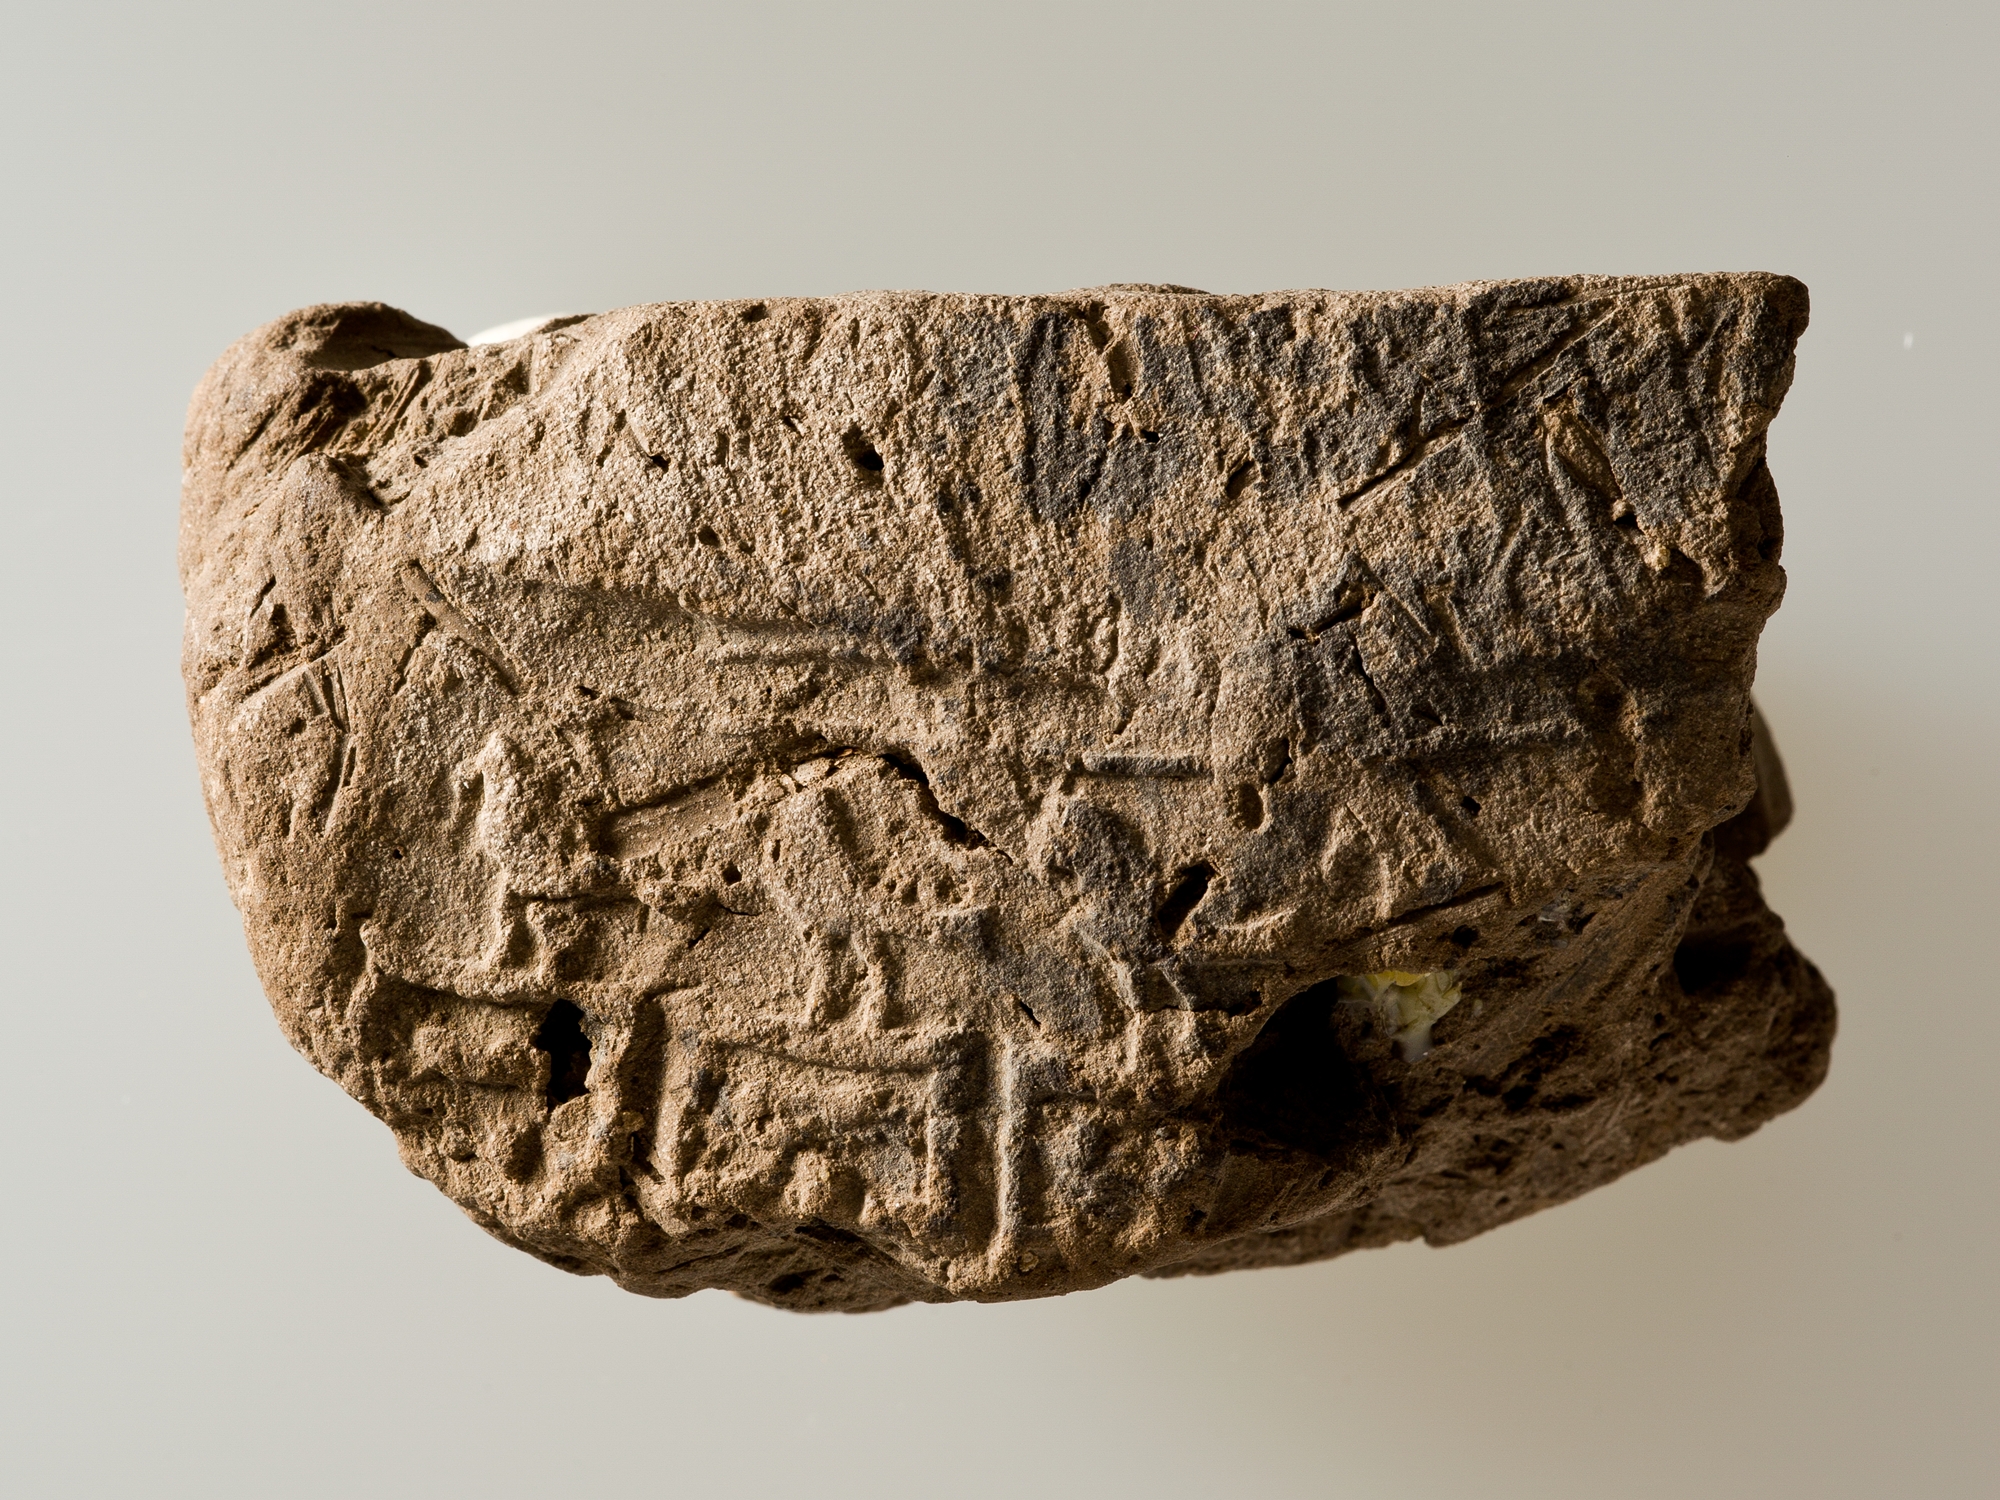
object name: sealing, jar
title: Mud jar sealing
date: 3200-2650 BCE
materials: clay, mud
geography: egypt